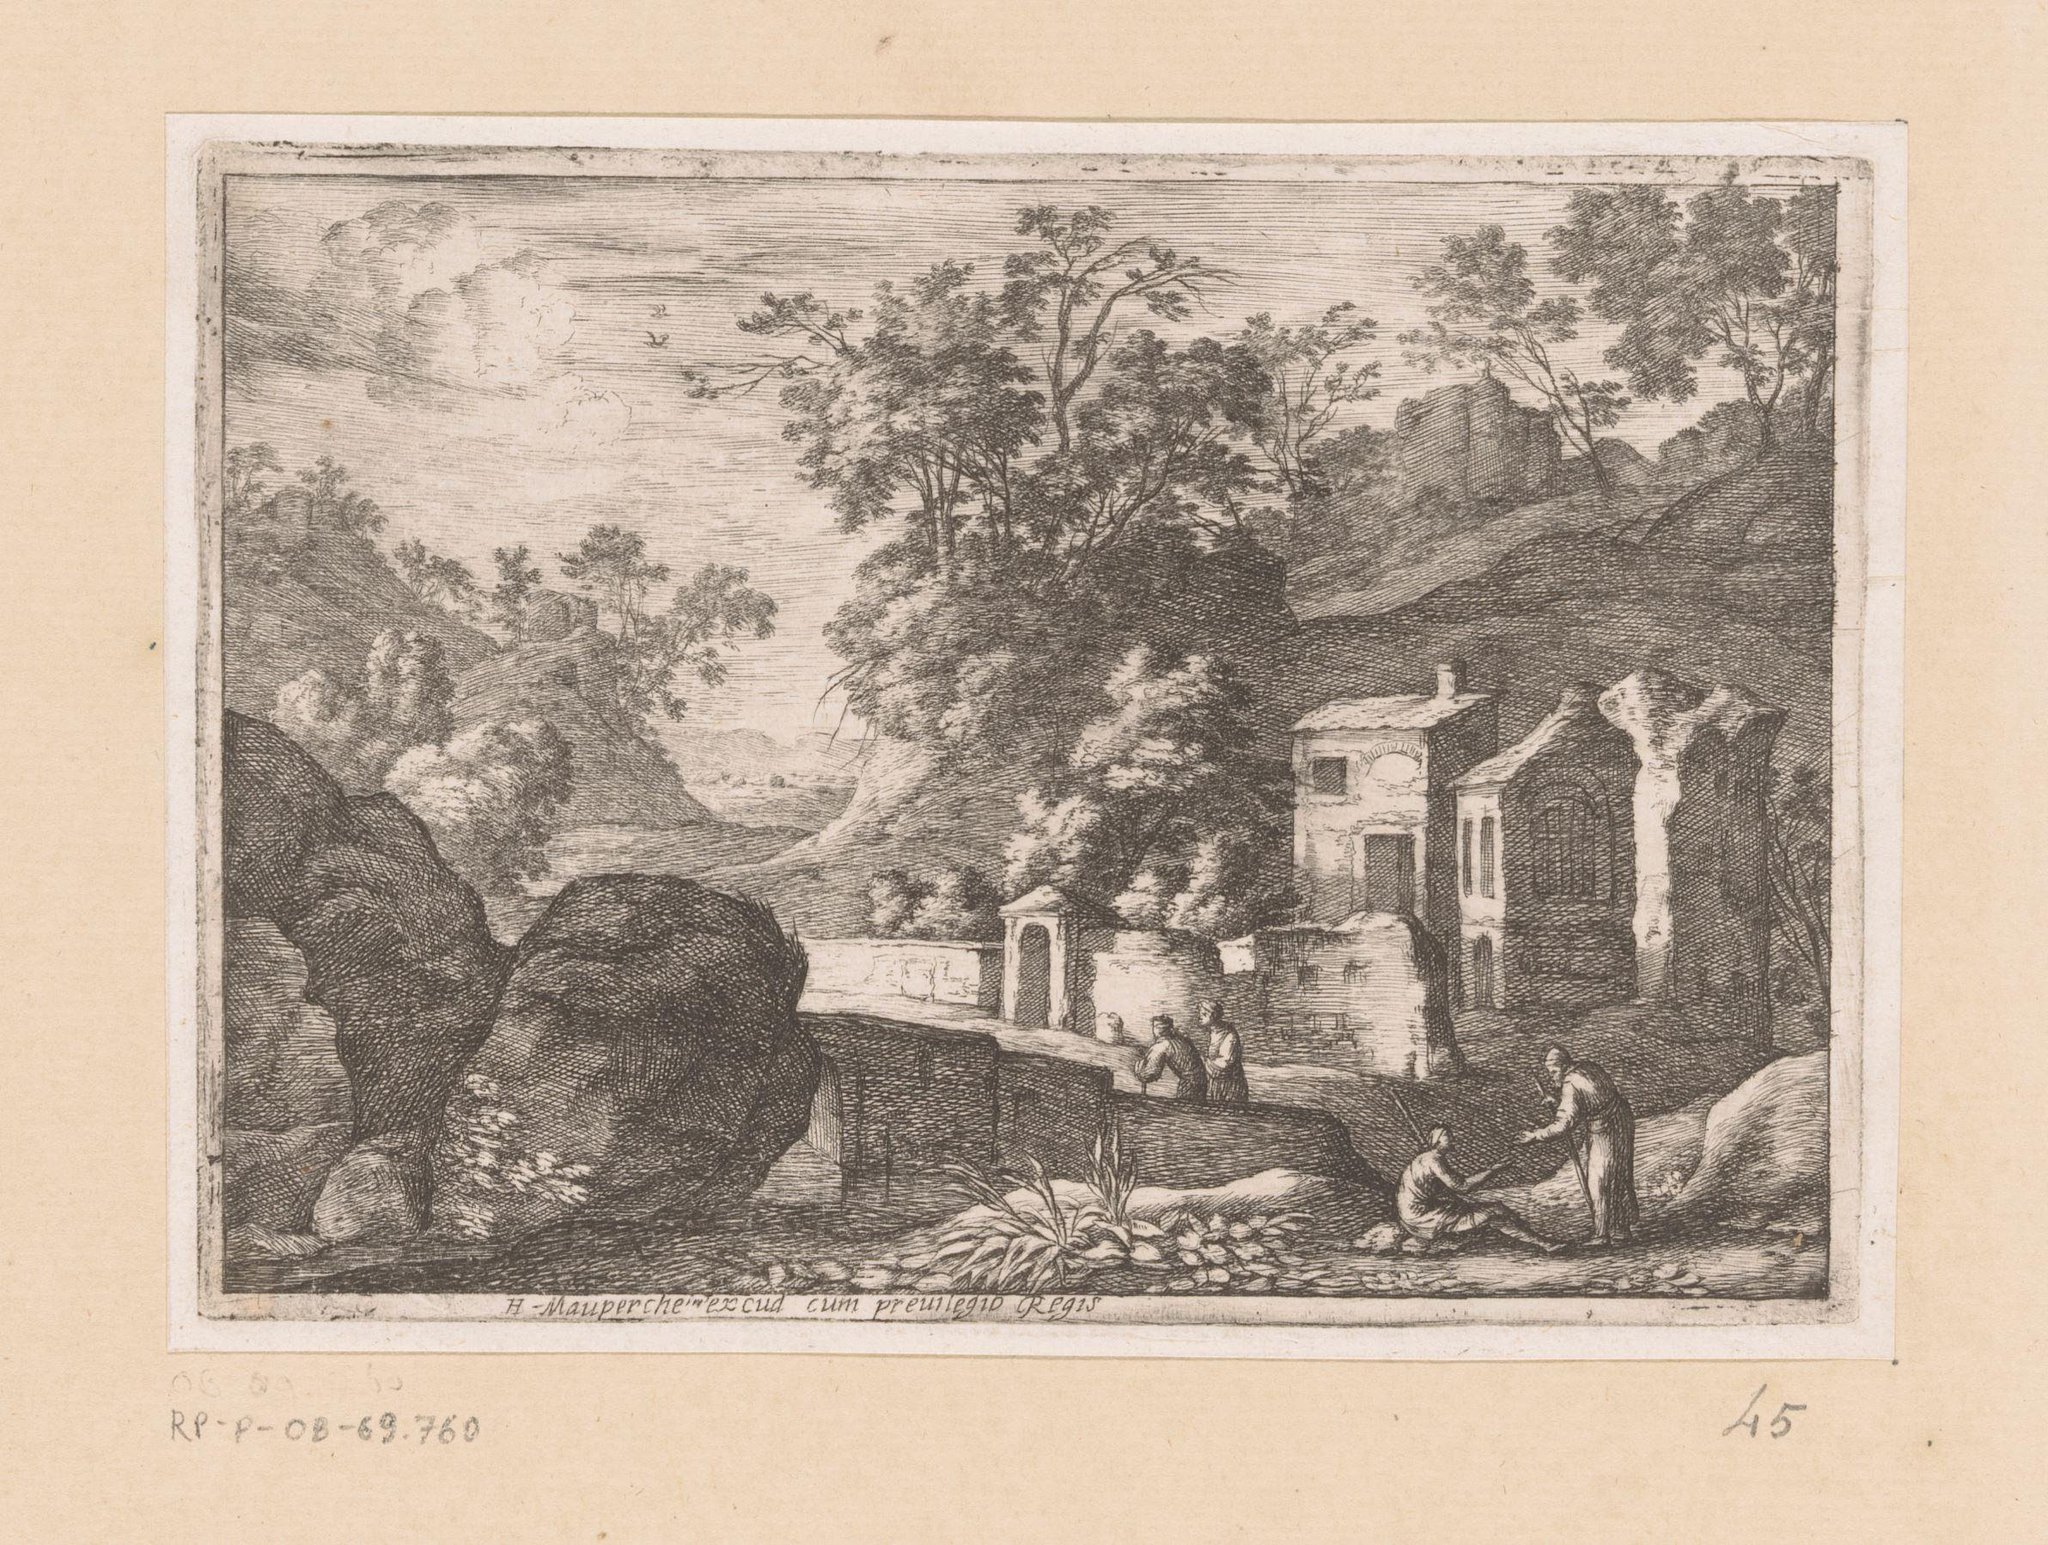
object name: print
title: Heuvelachtig landschap met huizen achter ommuring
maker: henri mauperché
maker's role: painter, print maker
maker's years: 1602-1686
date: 1612-1686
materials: paper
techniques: engraving, etching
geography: paris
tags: rural housing, e.g. country-house, villa, cottage, (high) hill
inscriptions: collector's mark: Lugt 240